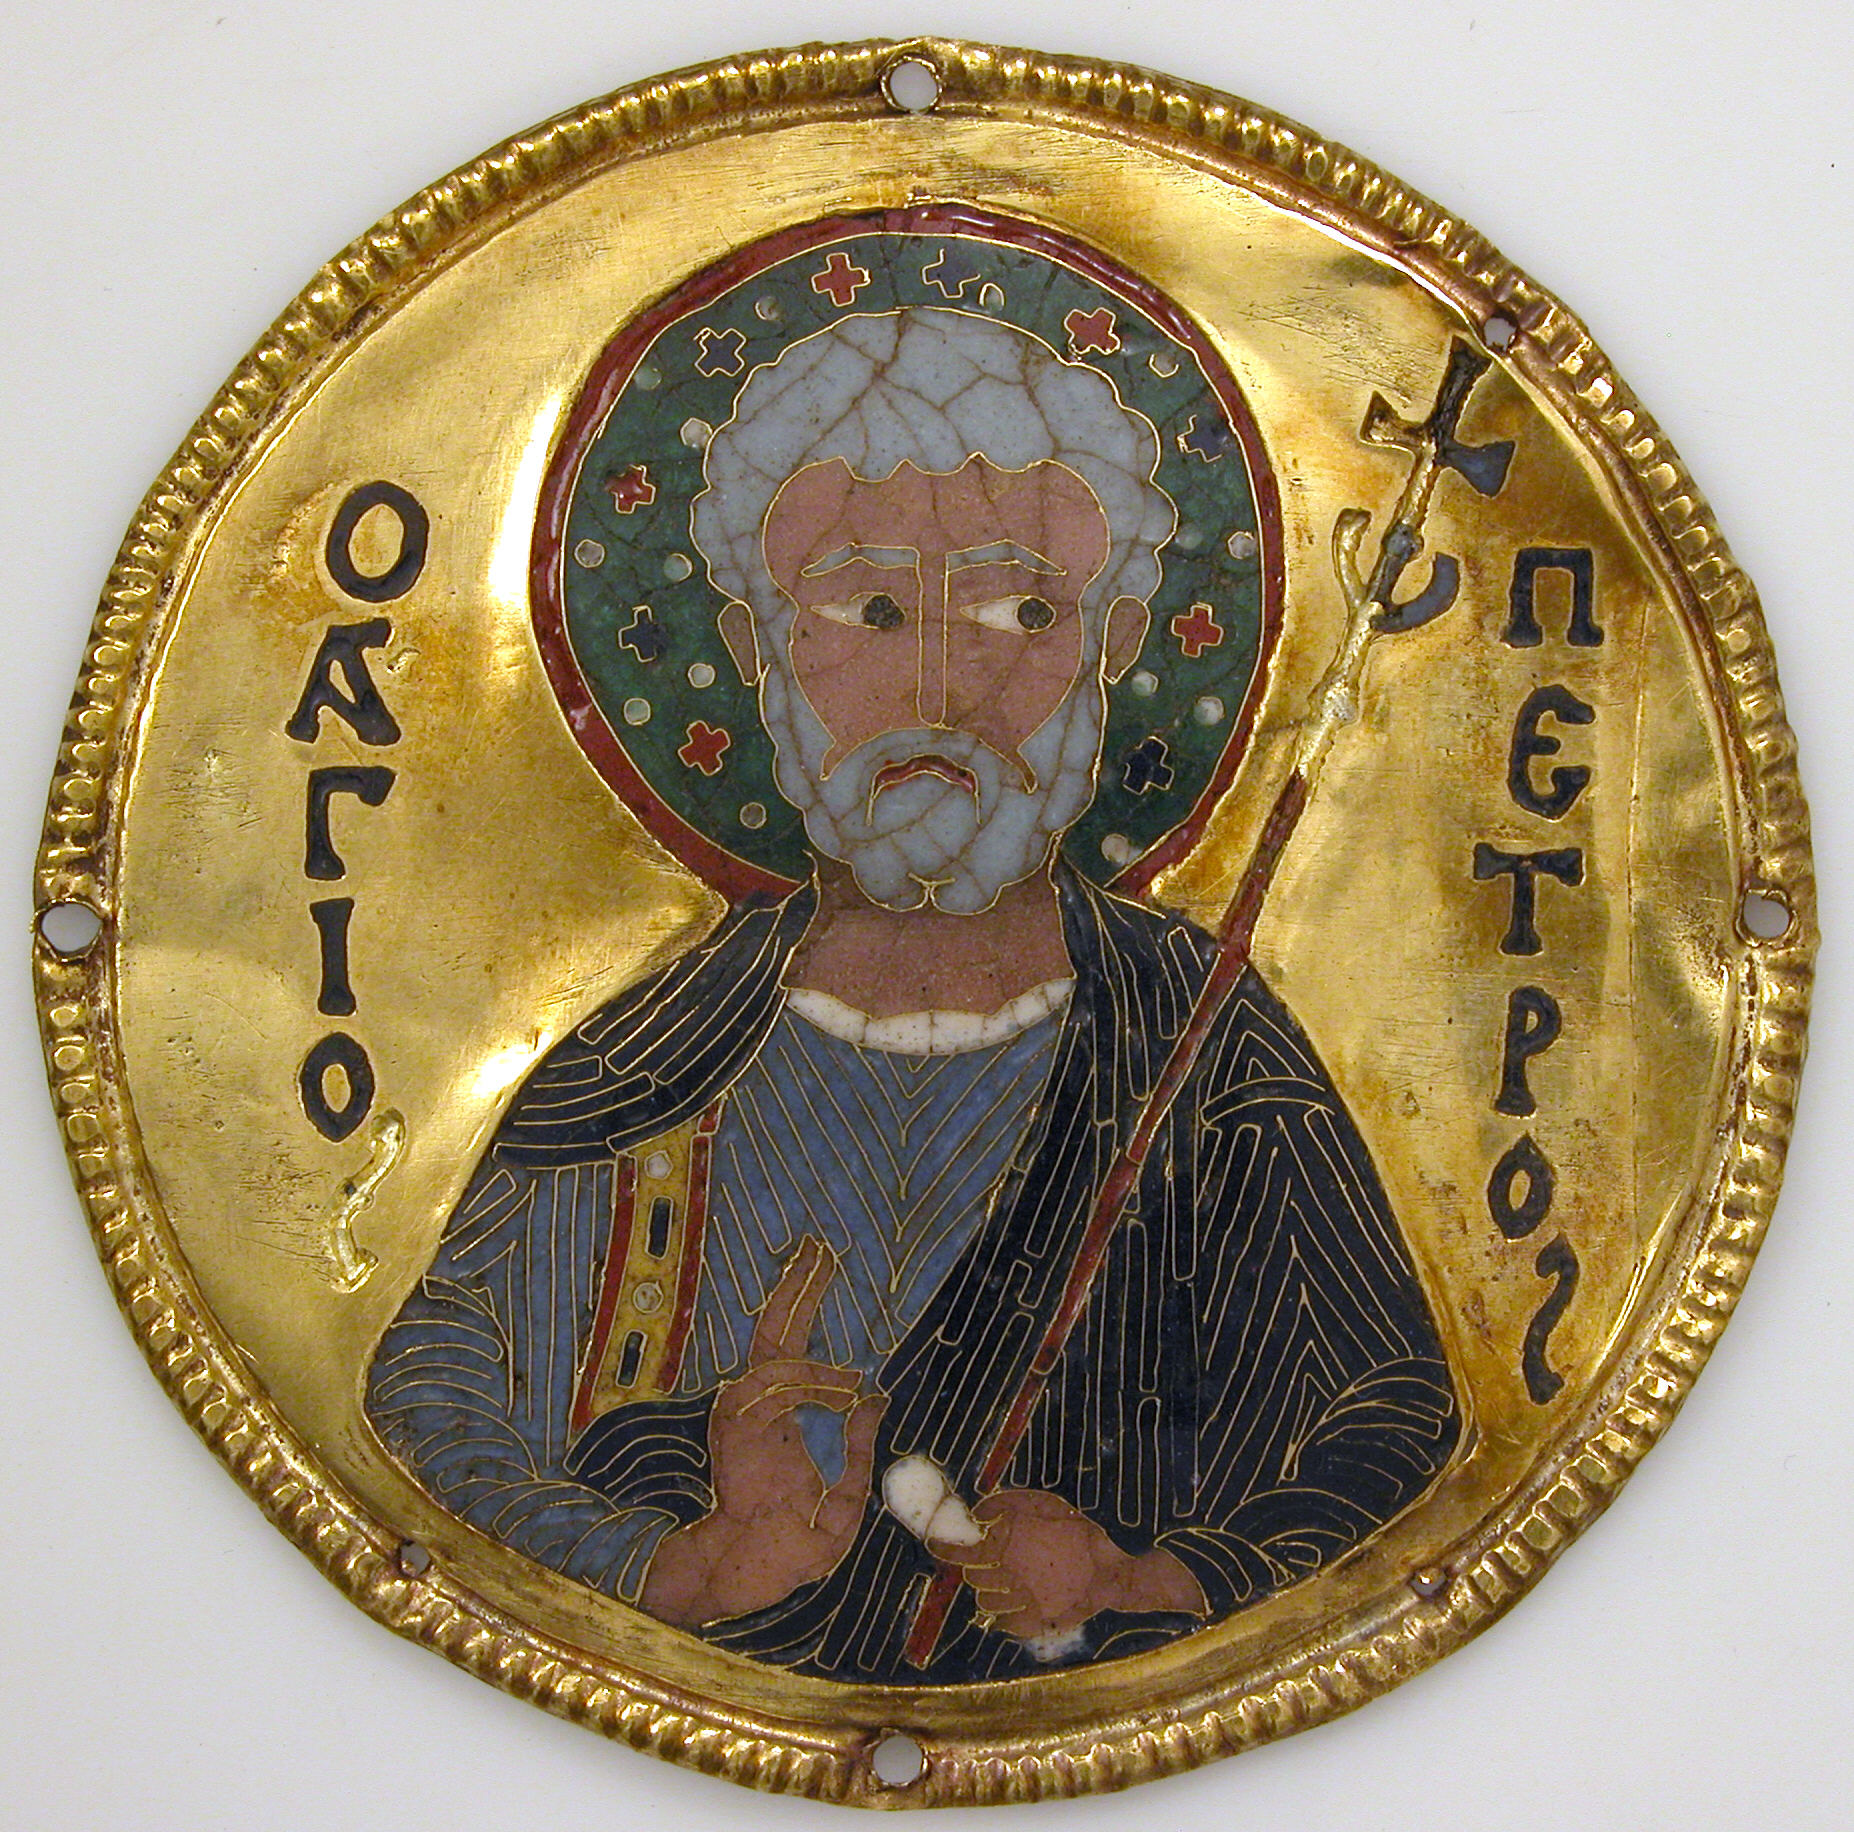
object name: medallion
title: Medallion with Saint Peter from an Icon Frame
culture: byzantine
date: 1100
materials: enamel, gold, silver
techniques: enamel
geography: constantinople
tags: saint peter